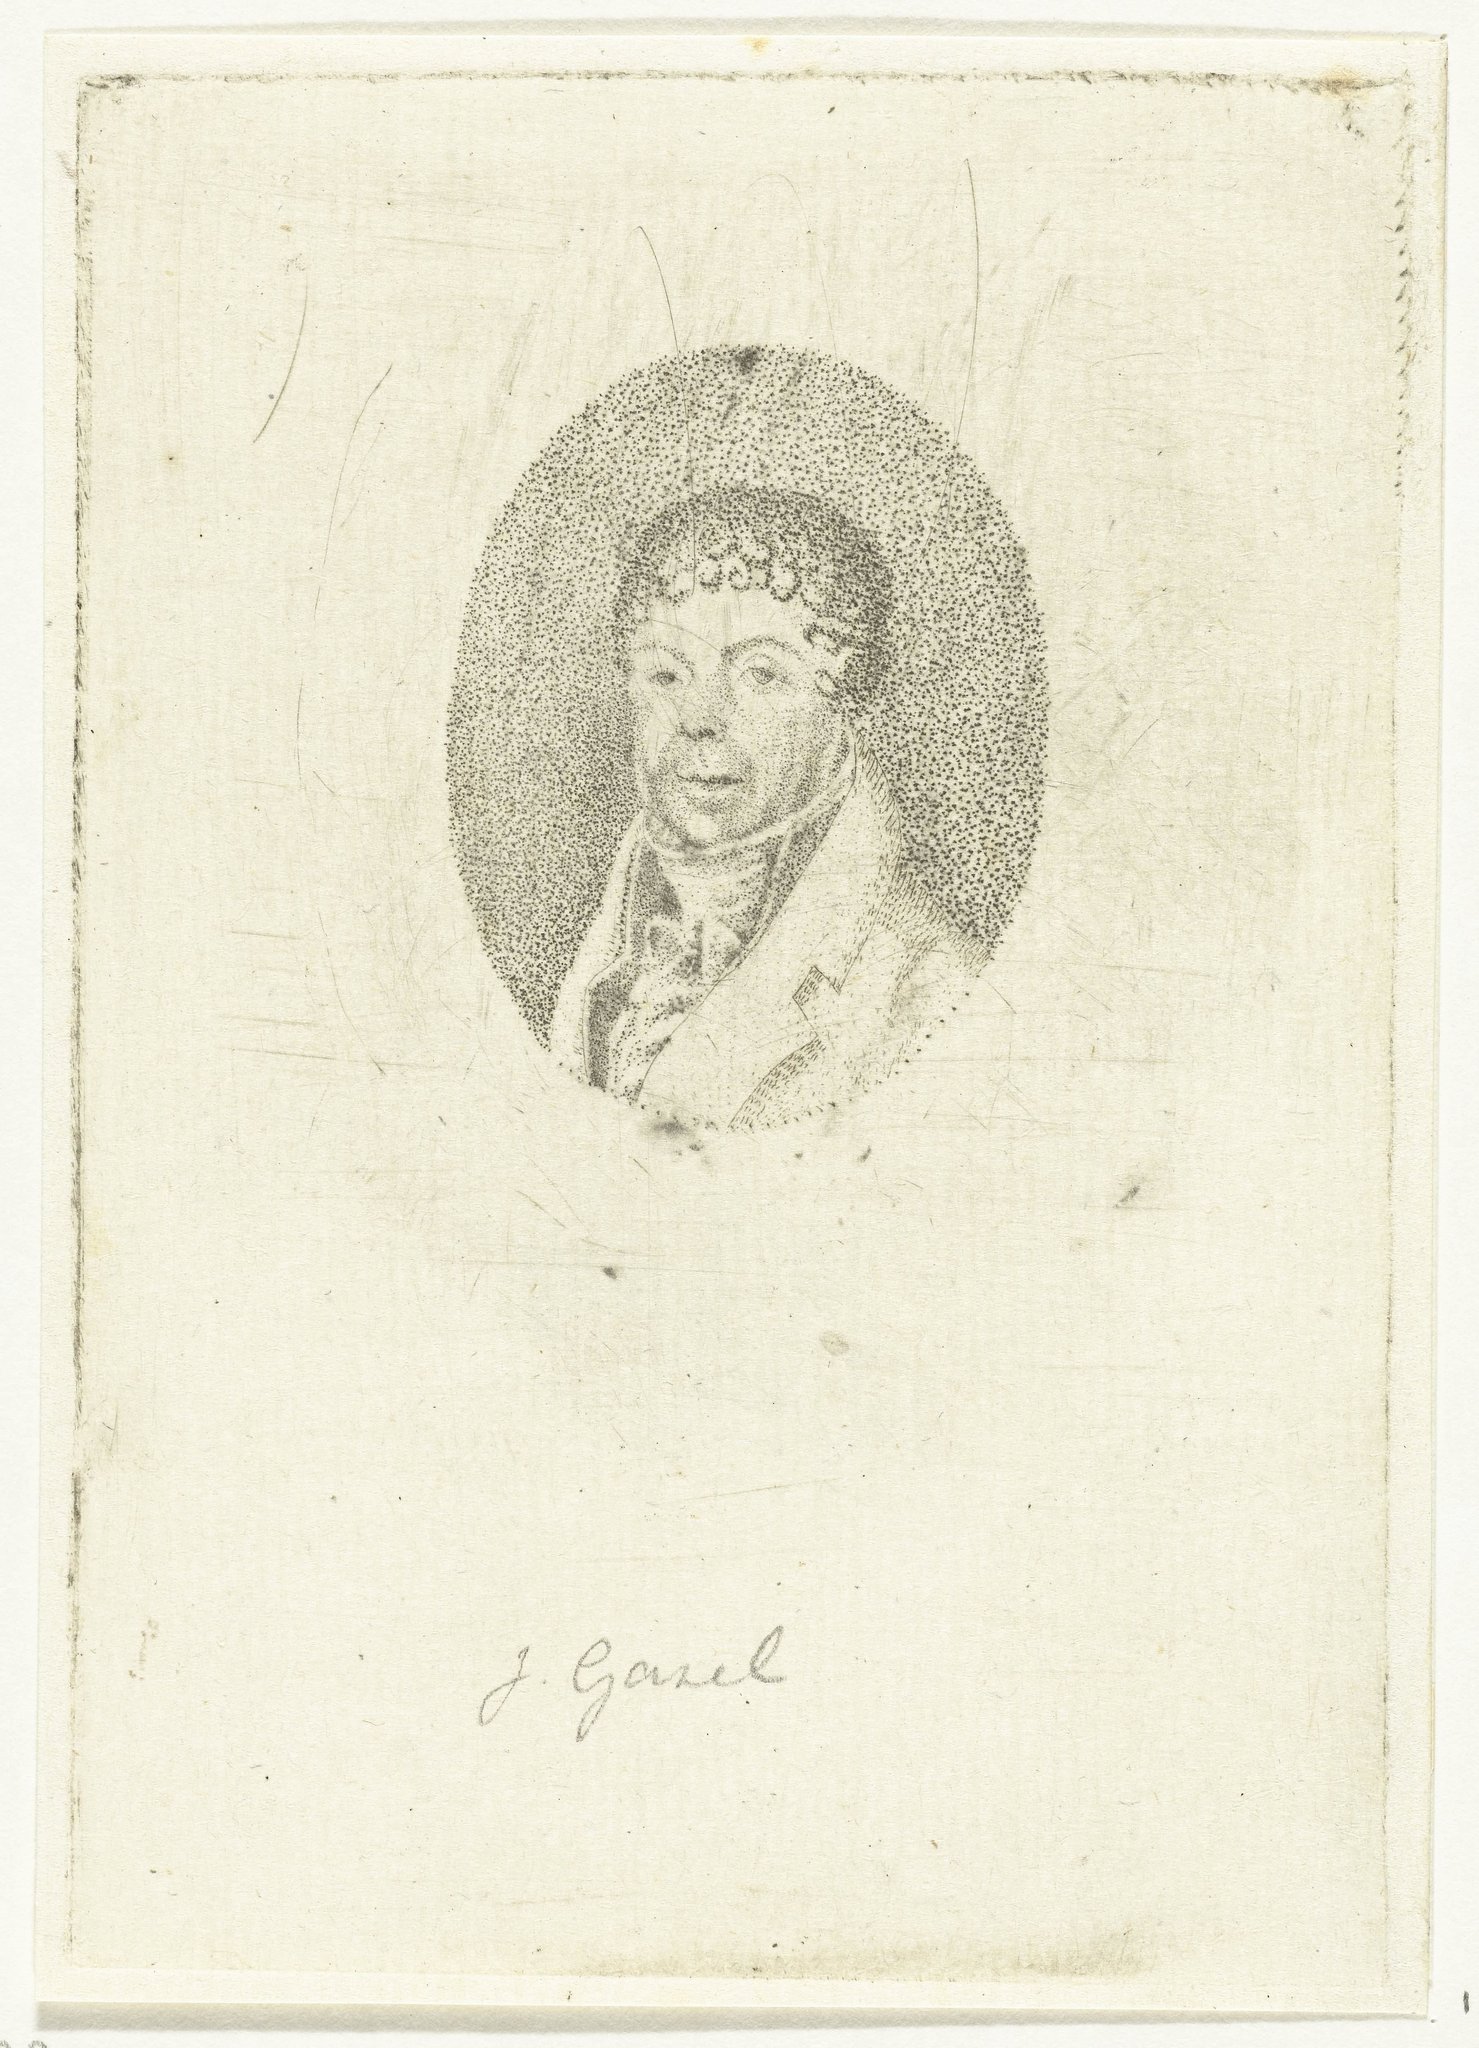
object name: print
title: Portret van J. Gazel, in ovaal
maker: anthonie van den bos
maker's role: draughtsman, print maker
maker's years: 1763-1838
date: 1800-1838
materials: paper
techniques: stippled etching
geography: netherlands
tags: anonymous historical person portrayed alone (+ three-quarter view portrait)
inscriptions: collector's mark: Lugt 2228